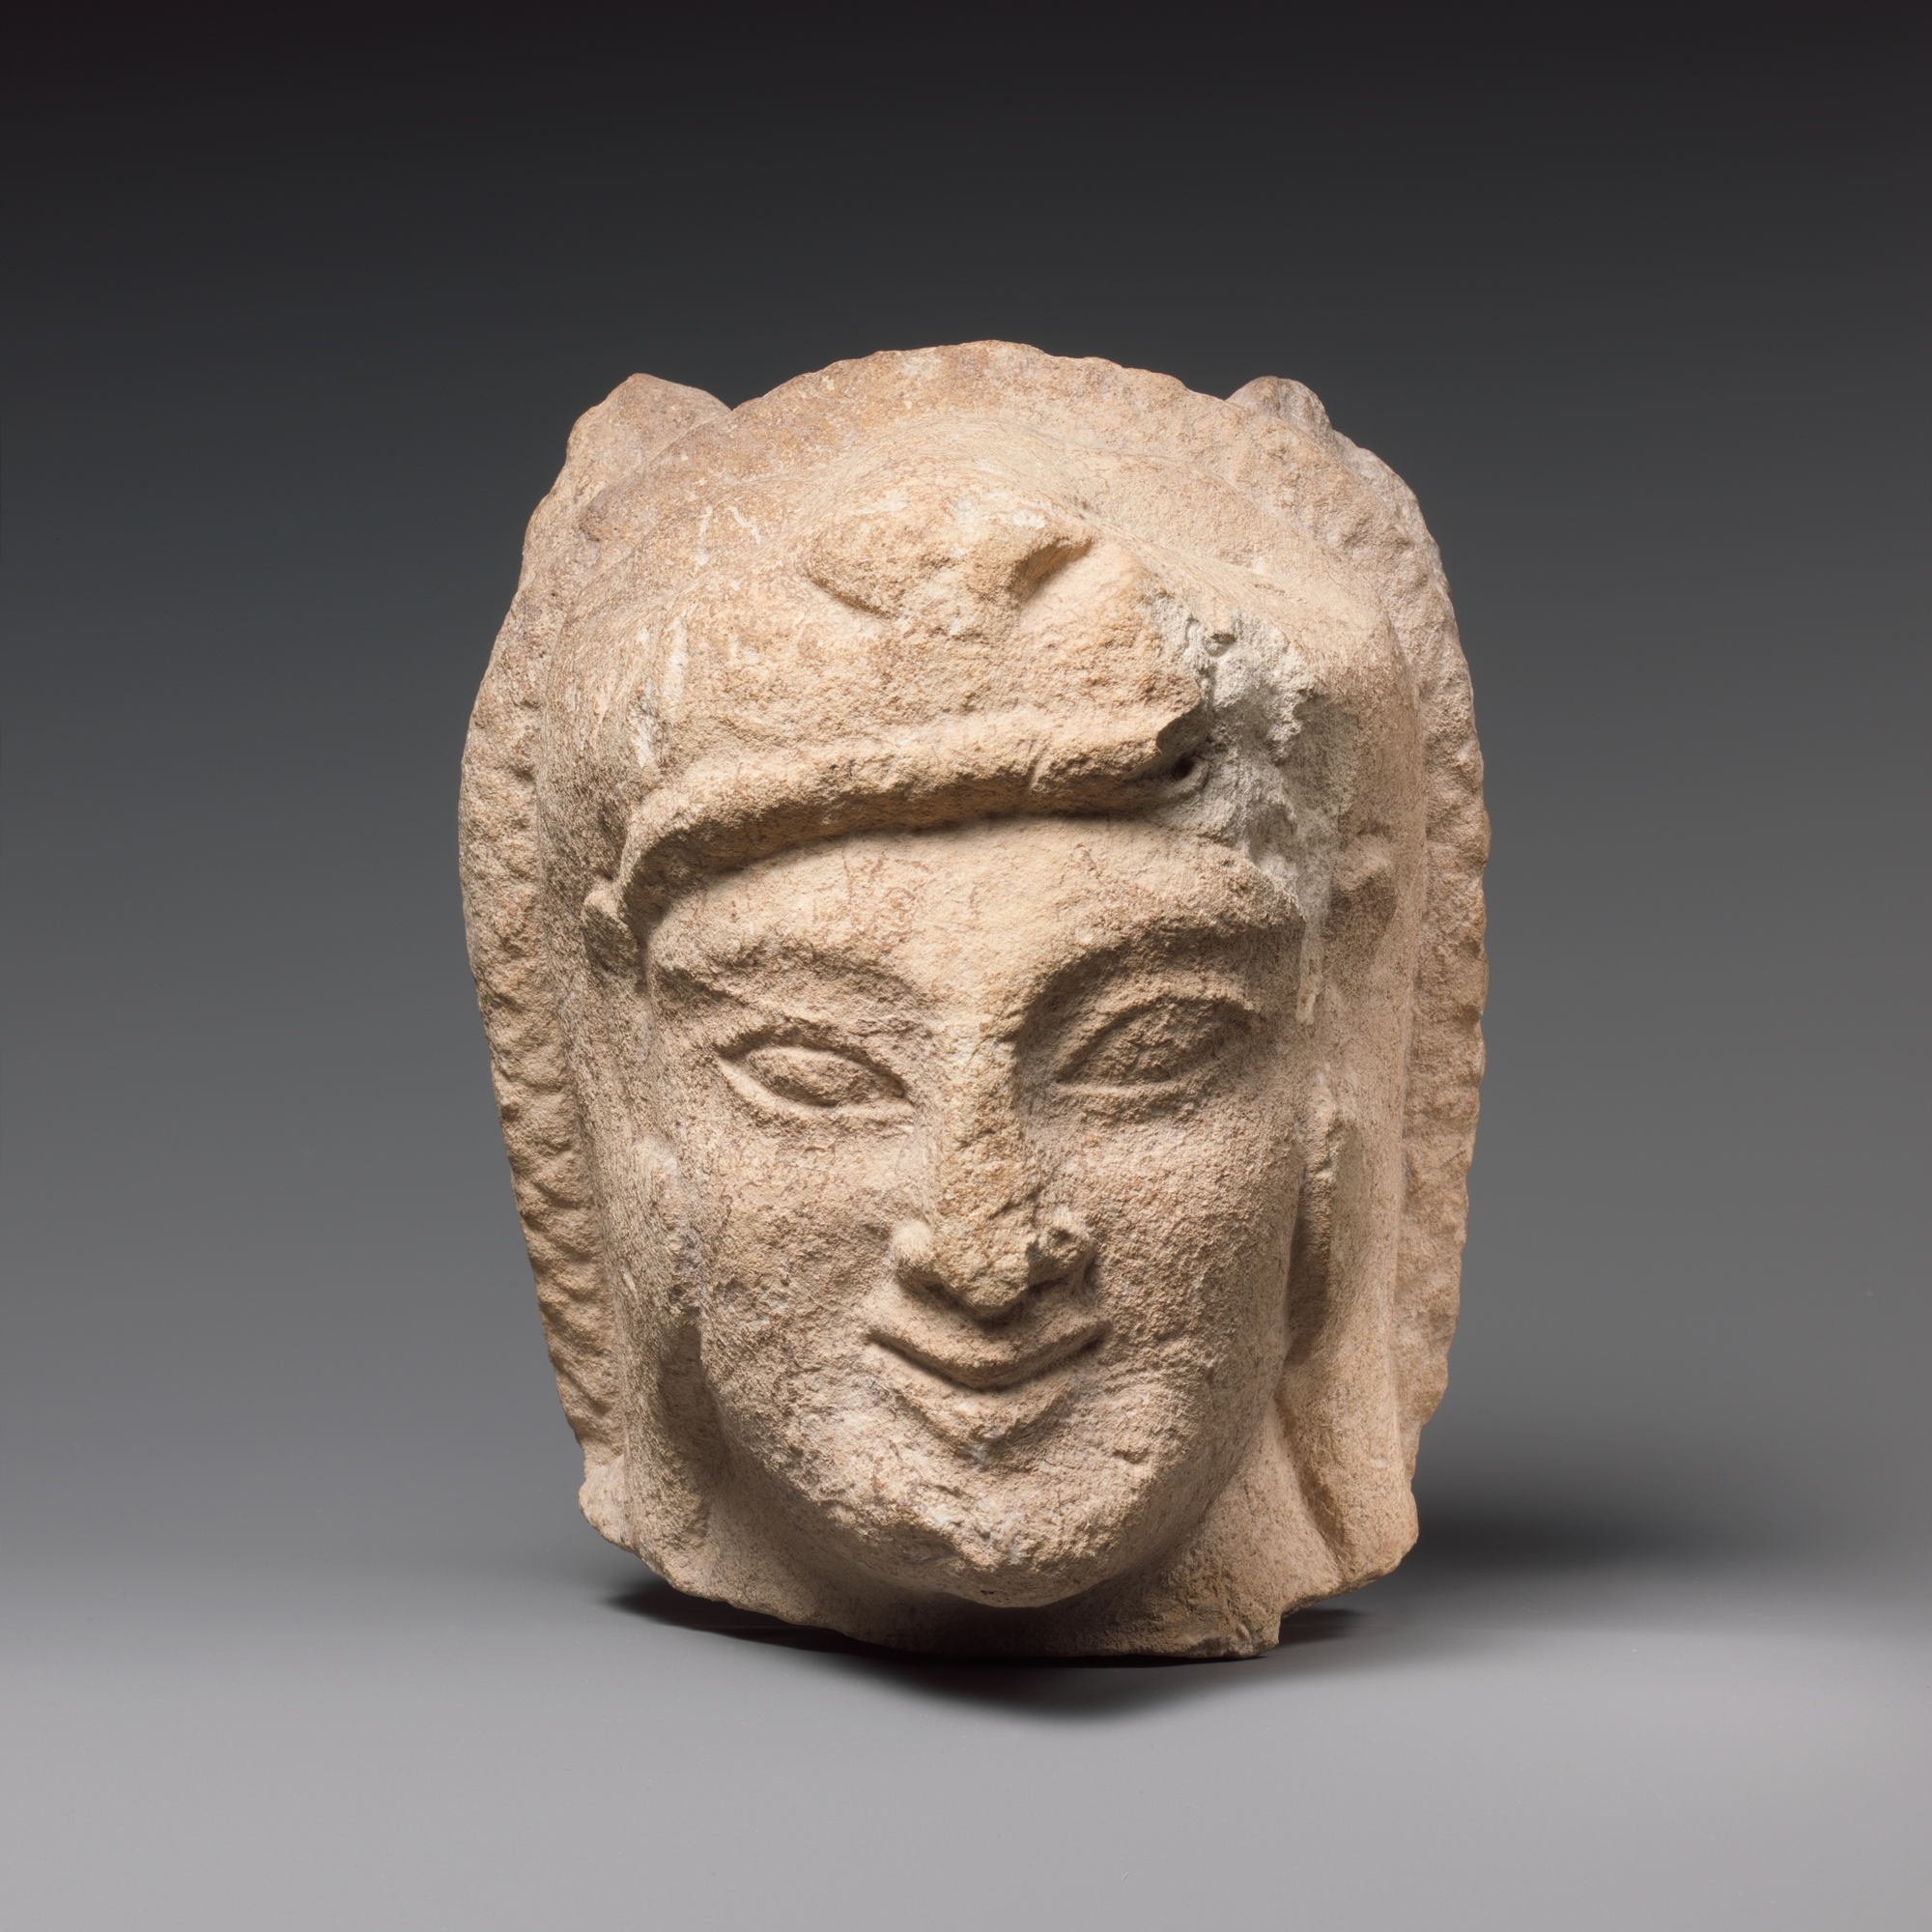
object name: head of herakles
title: Limestone head of Herakles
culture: cypriot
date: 600-501 BCE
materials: limestone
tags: heads,herakles